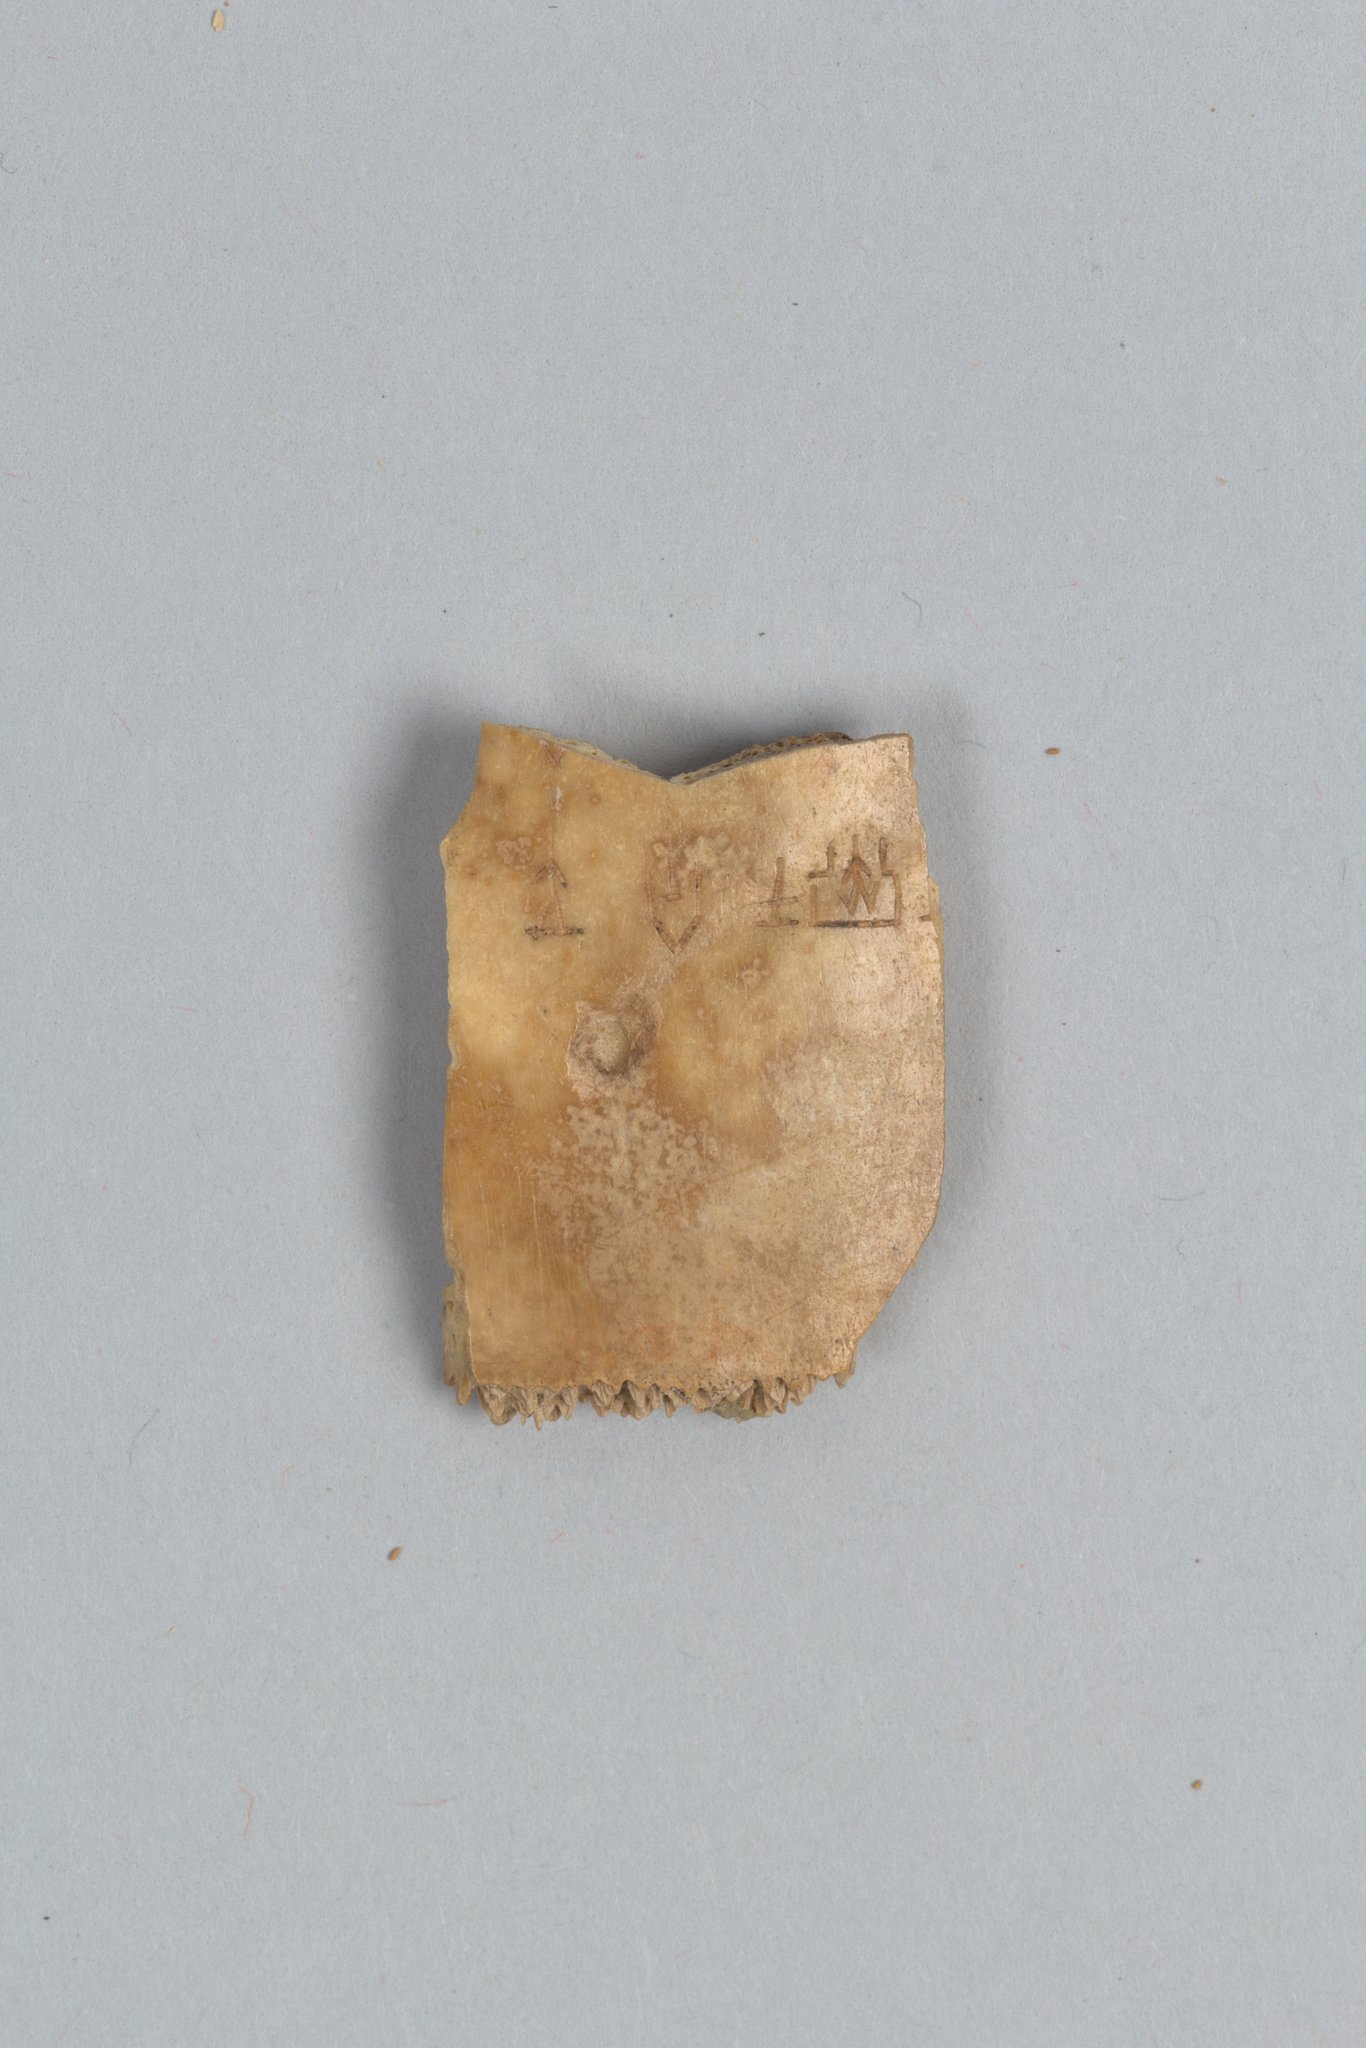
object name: oracle bone fragment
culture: chinese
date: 1600-1046 BCE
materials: bone